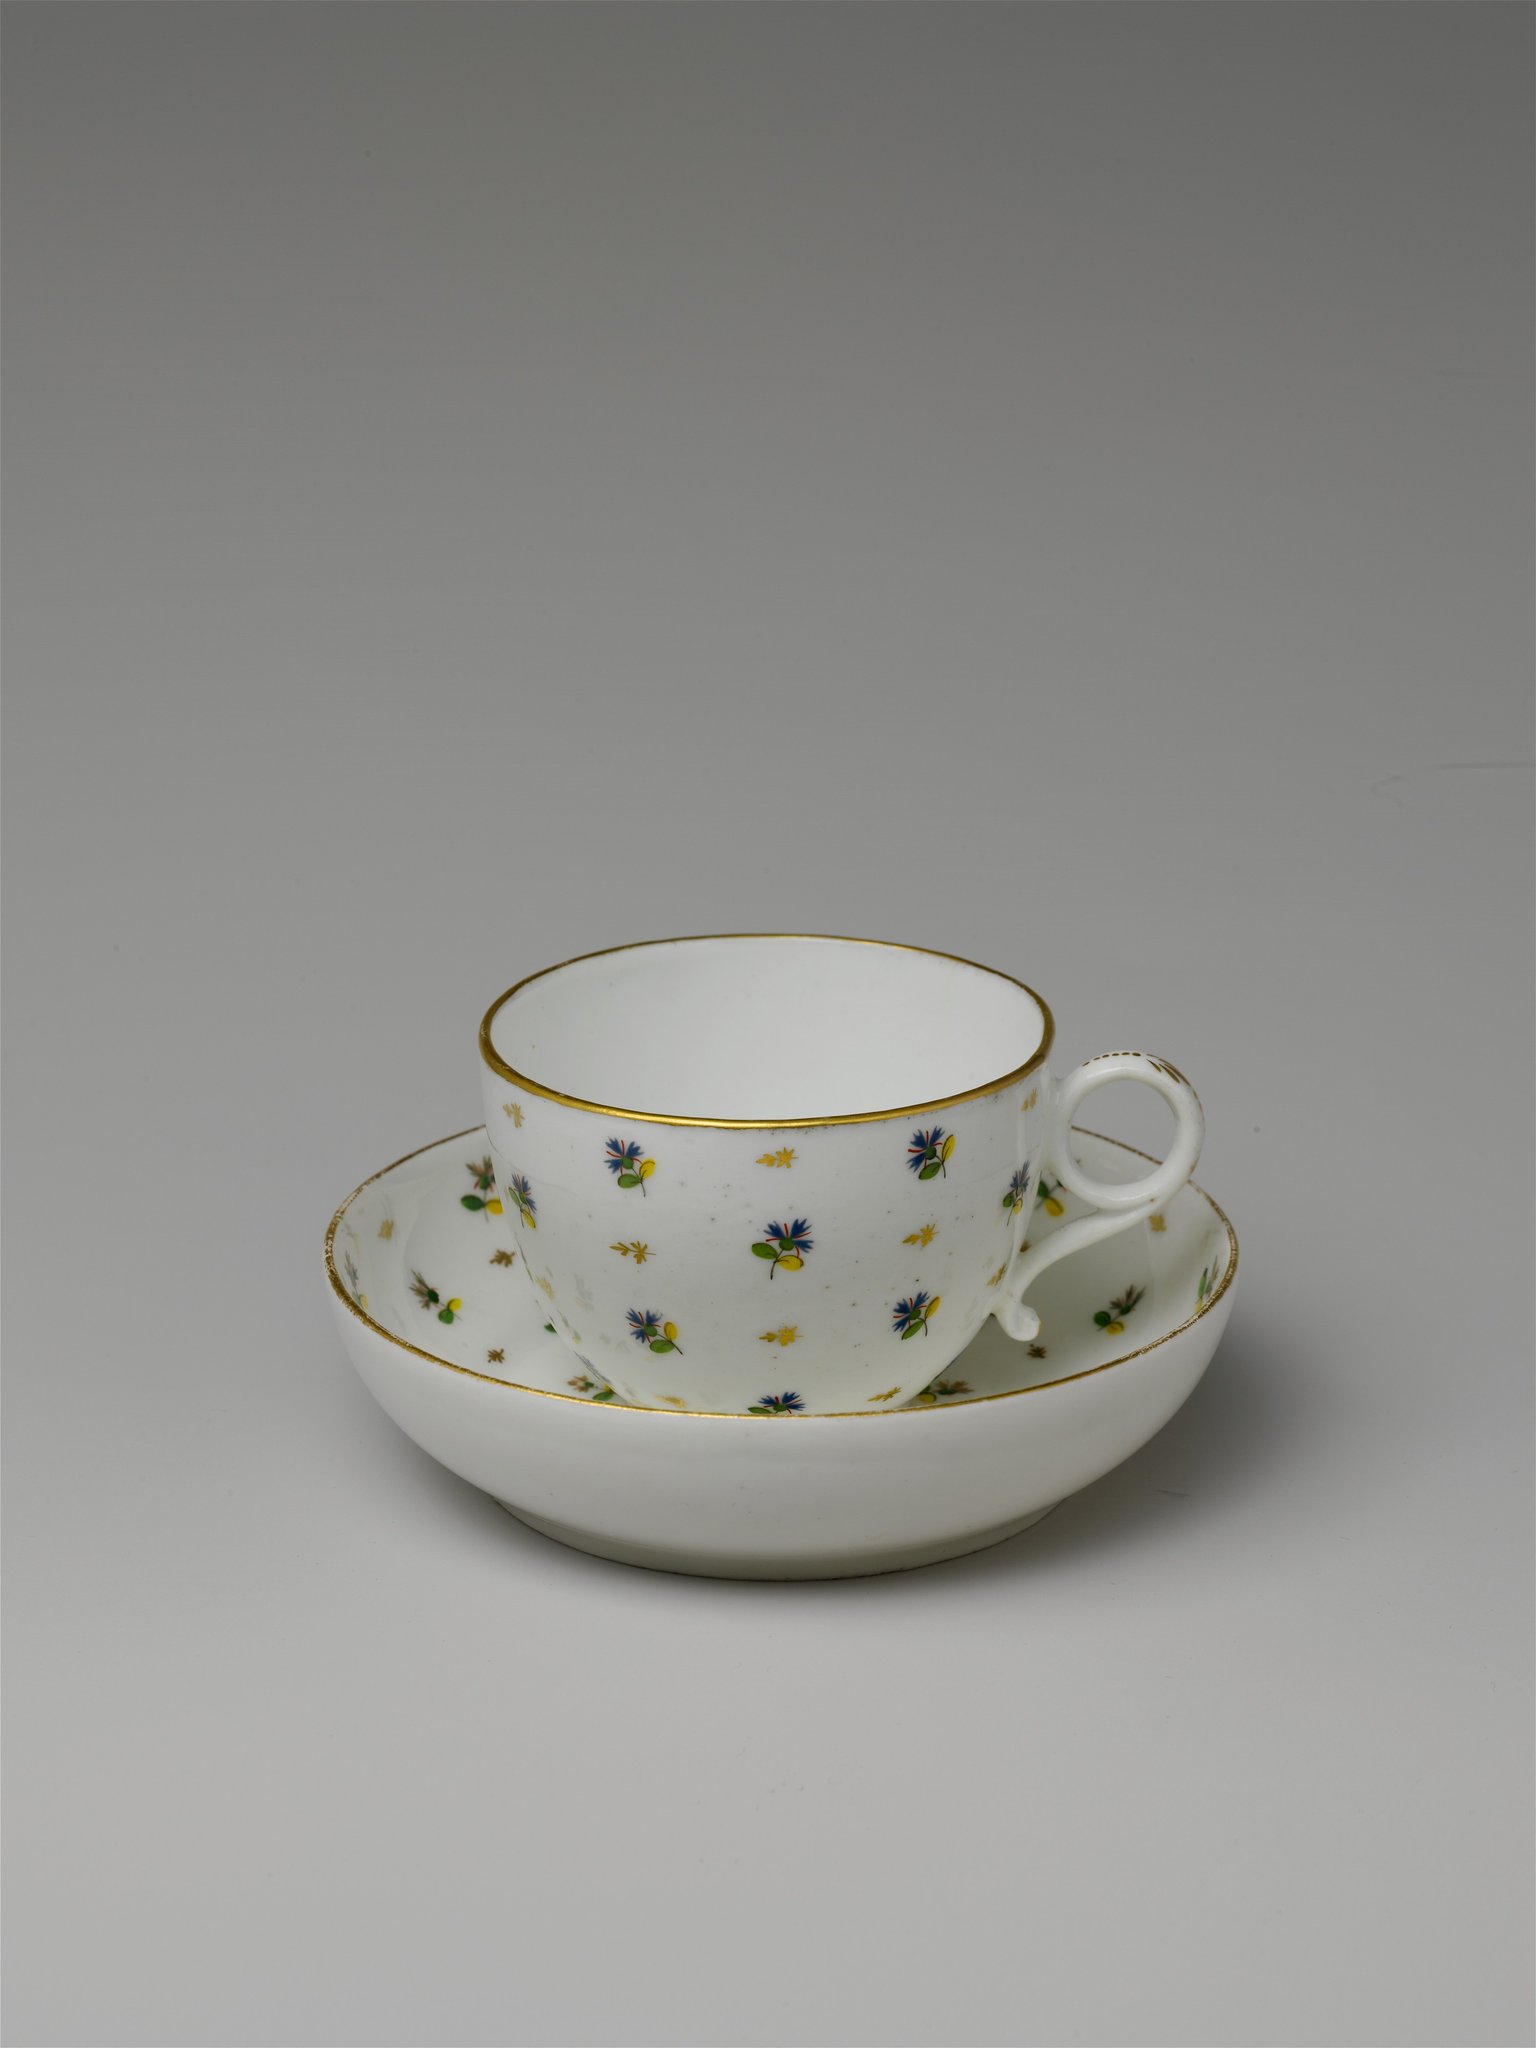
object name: cup and saucer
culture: french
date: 1780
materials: porcelain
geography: france